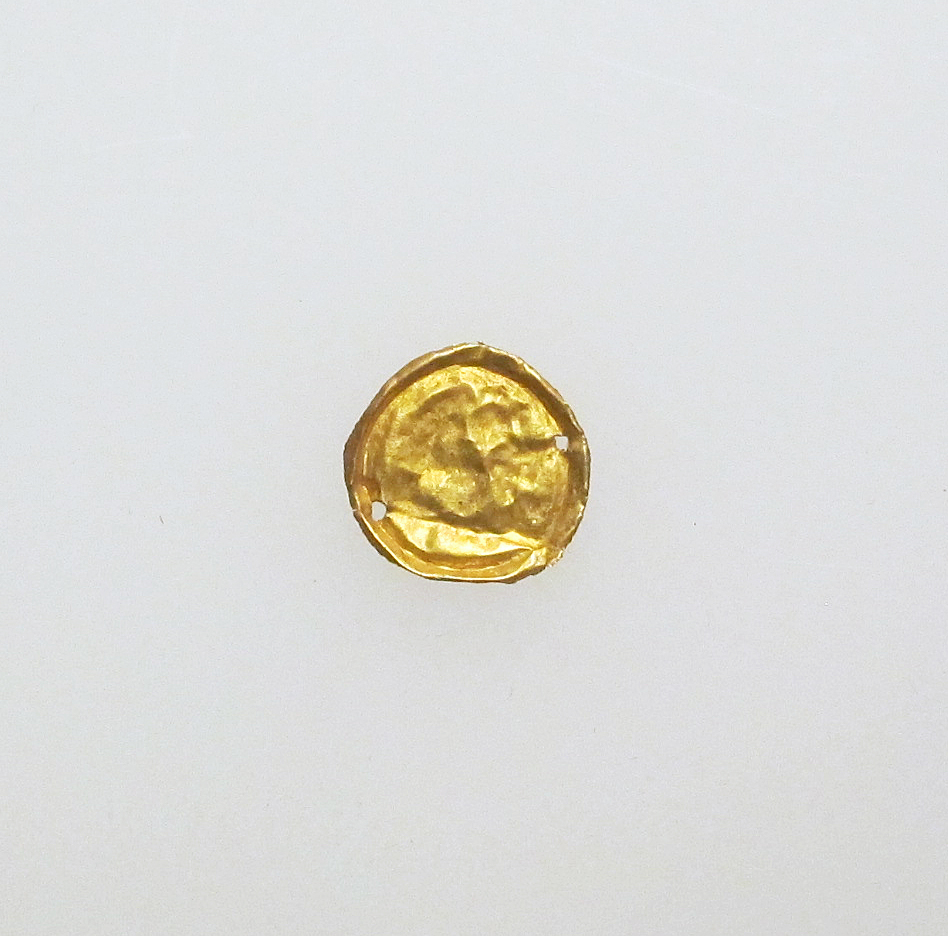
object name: bead ornament, circular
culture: roman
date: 201-300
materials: gold